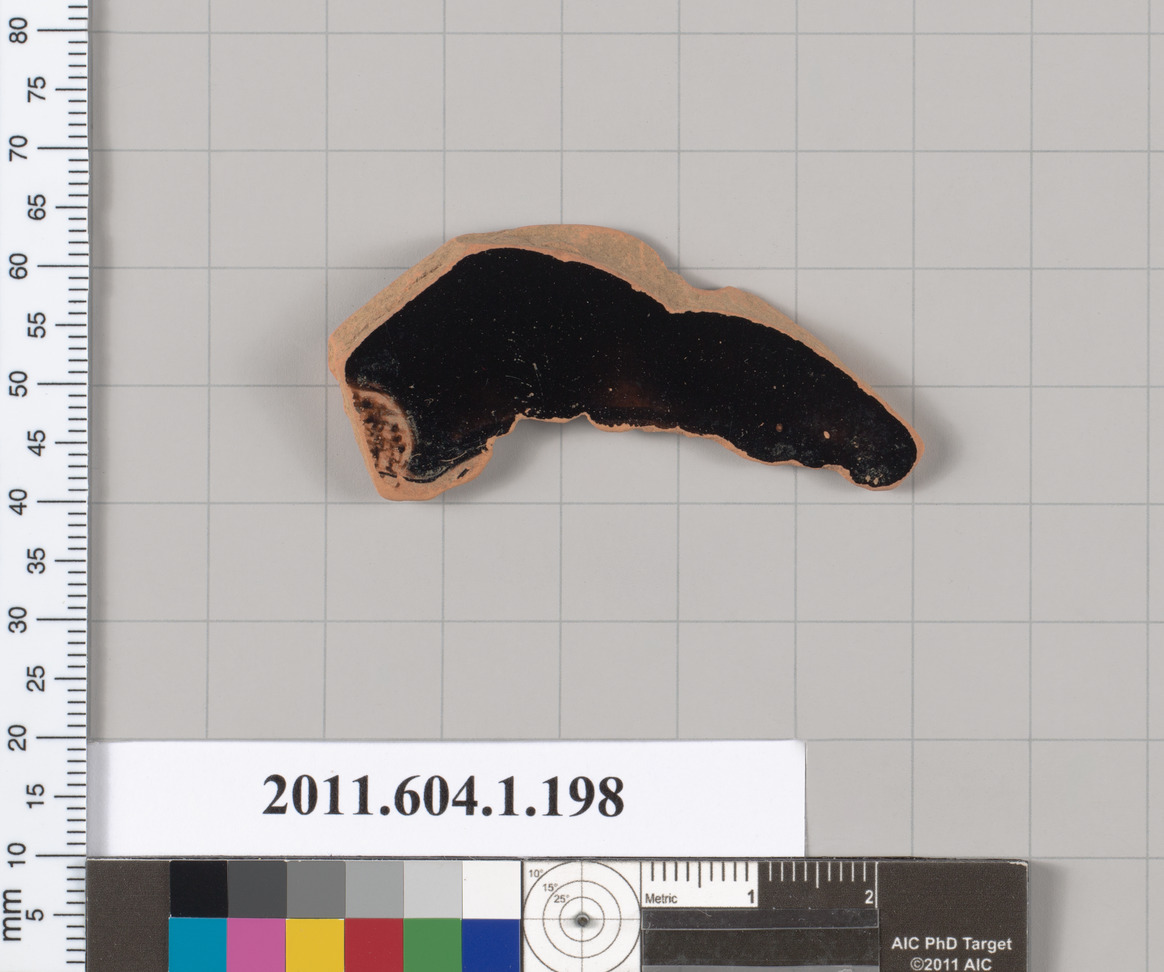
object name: kylix fragment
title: Terracotta fragment of a kylix (drinking cup)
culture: greek, attic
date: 475-451 BCE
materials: terracotta